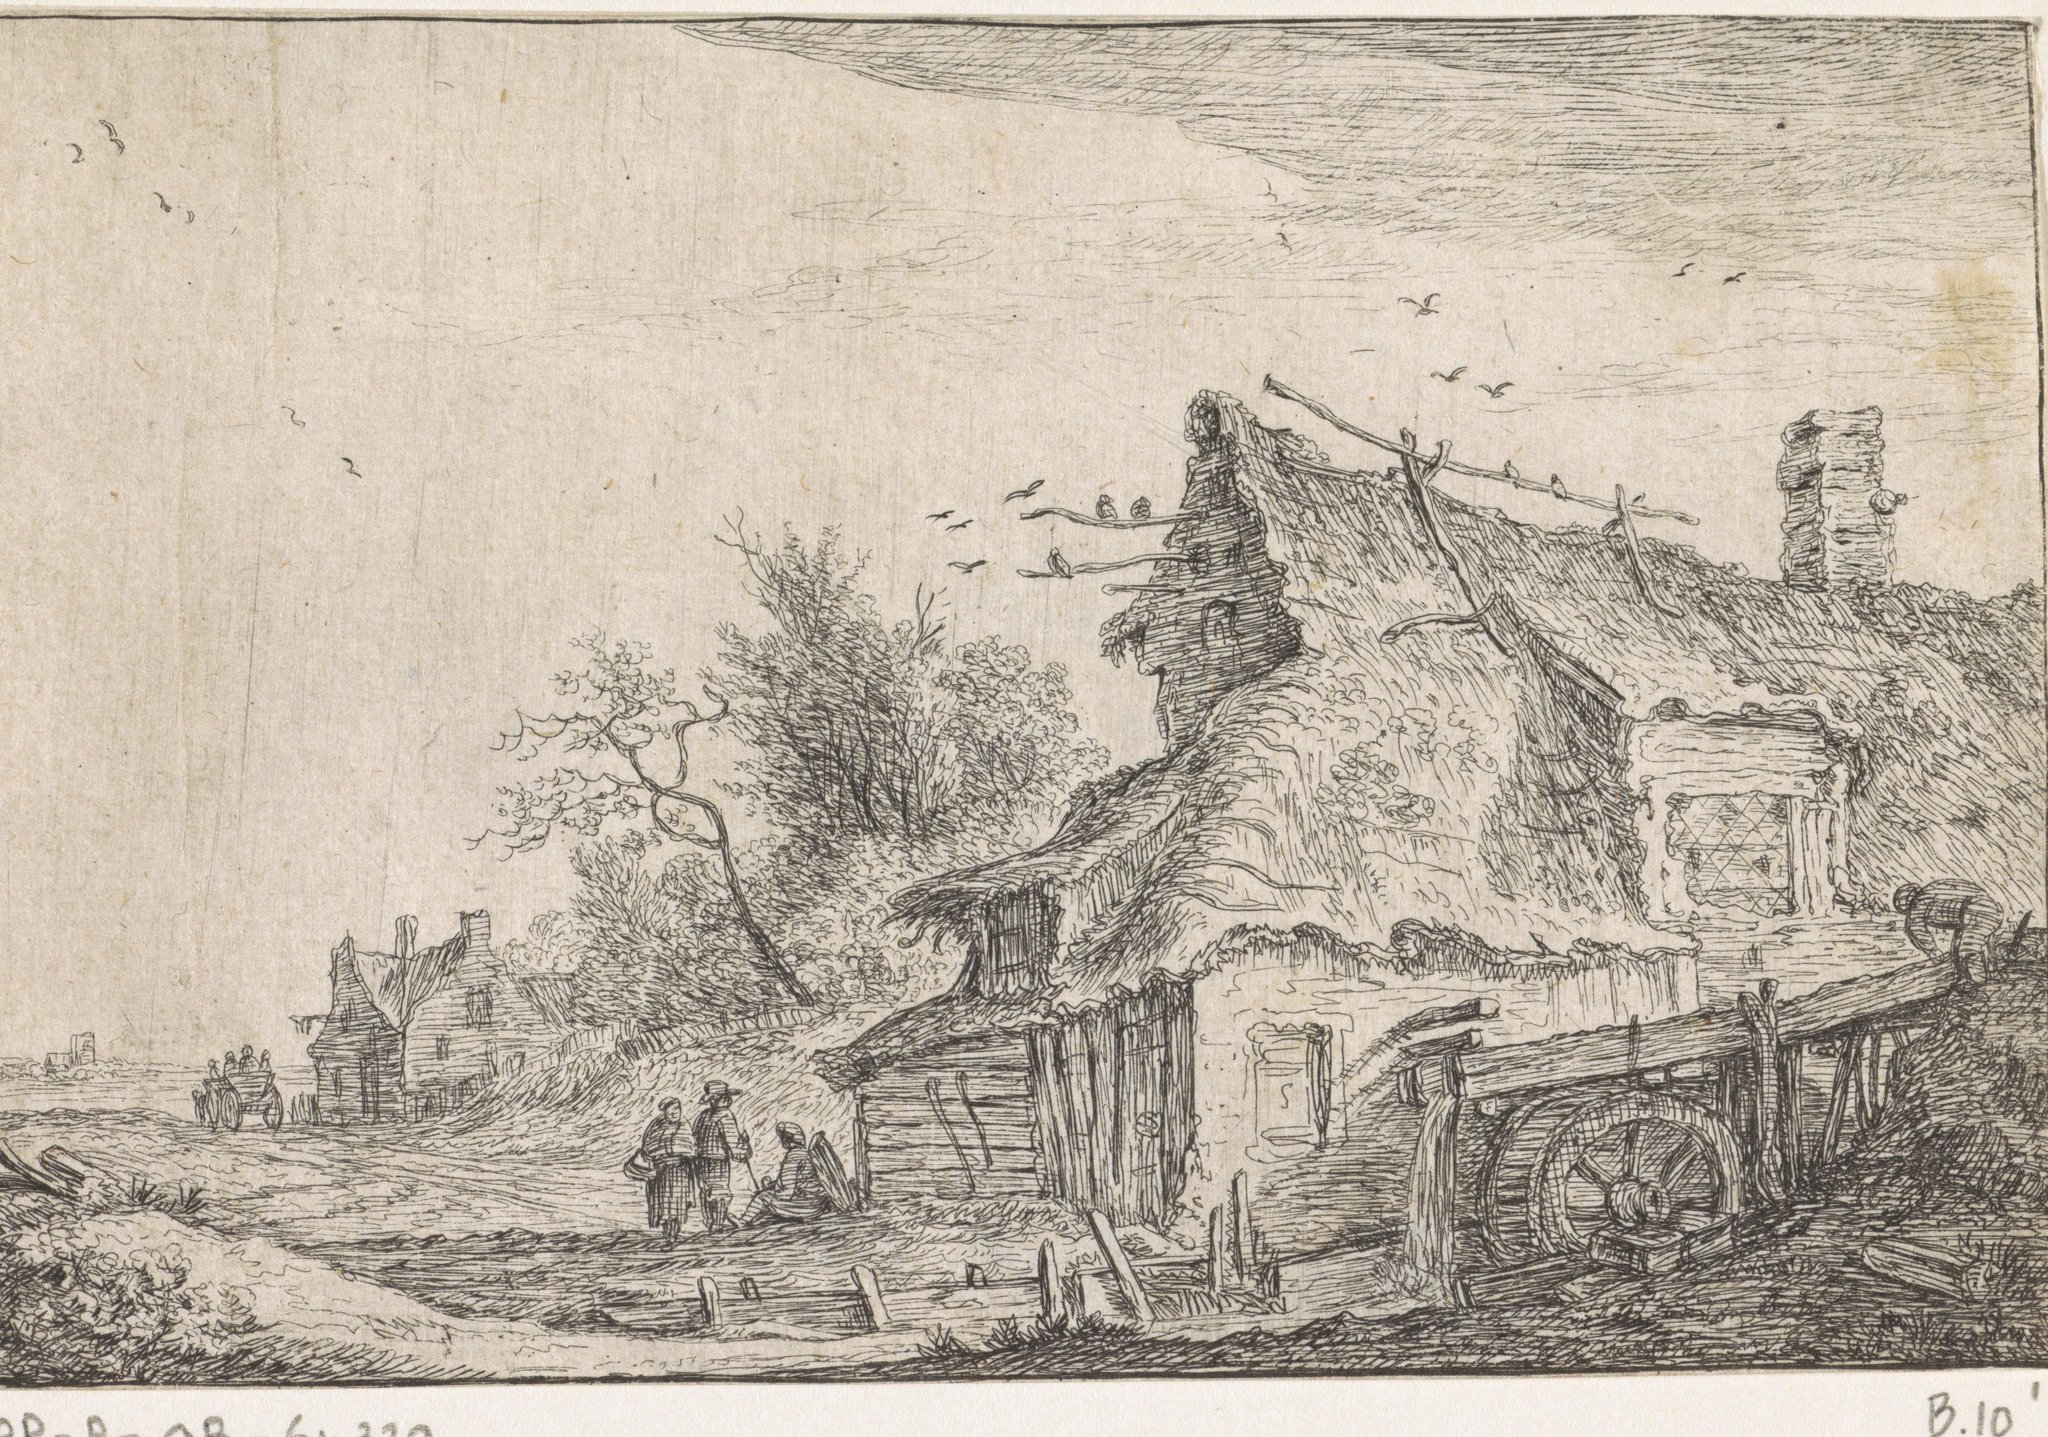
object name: print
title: Dorpsgezicht met een watermolen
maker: anthonie waterloo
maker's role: draughtsman, painter, print maker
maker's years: 1609-1690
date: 1630-1663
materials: paper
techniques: etching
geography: amsterdam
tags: village, watermill in landscape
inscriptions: collector's mark: Lugt 2228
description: In een landschap staan enkele huizen. Rechts staat een huis met een rieten dak en een watermolen. Aan de voorkant van het huis zijn enkele figuren weergegeven.